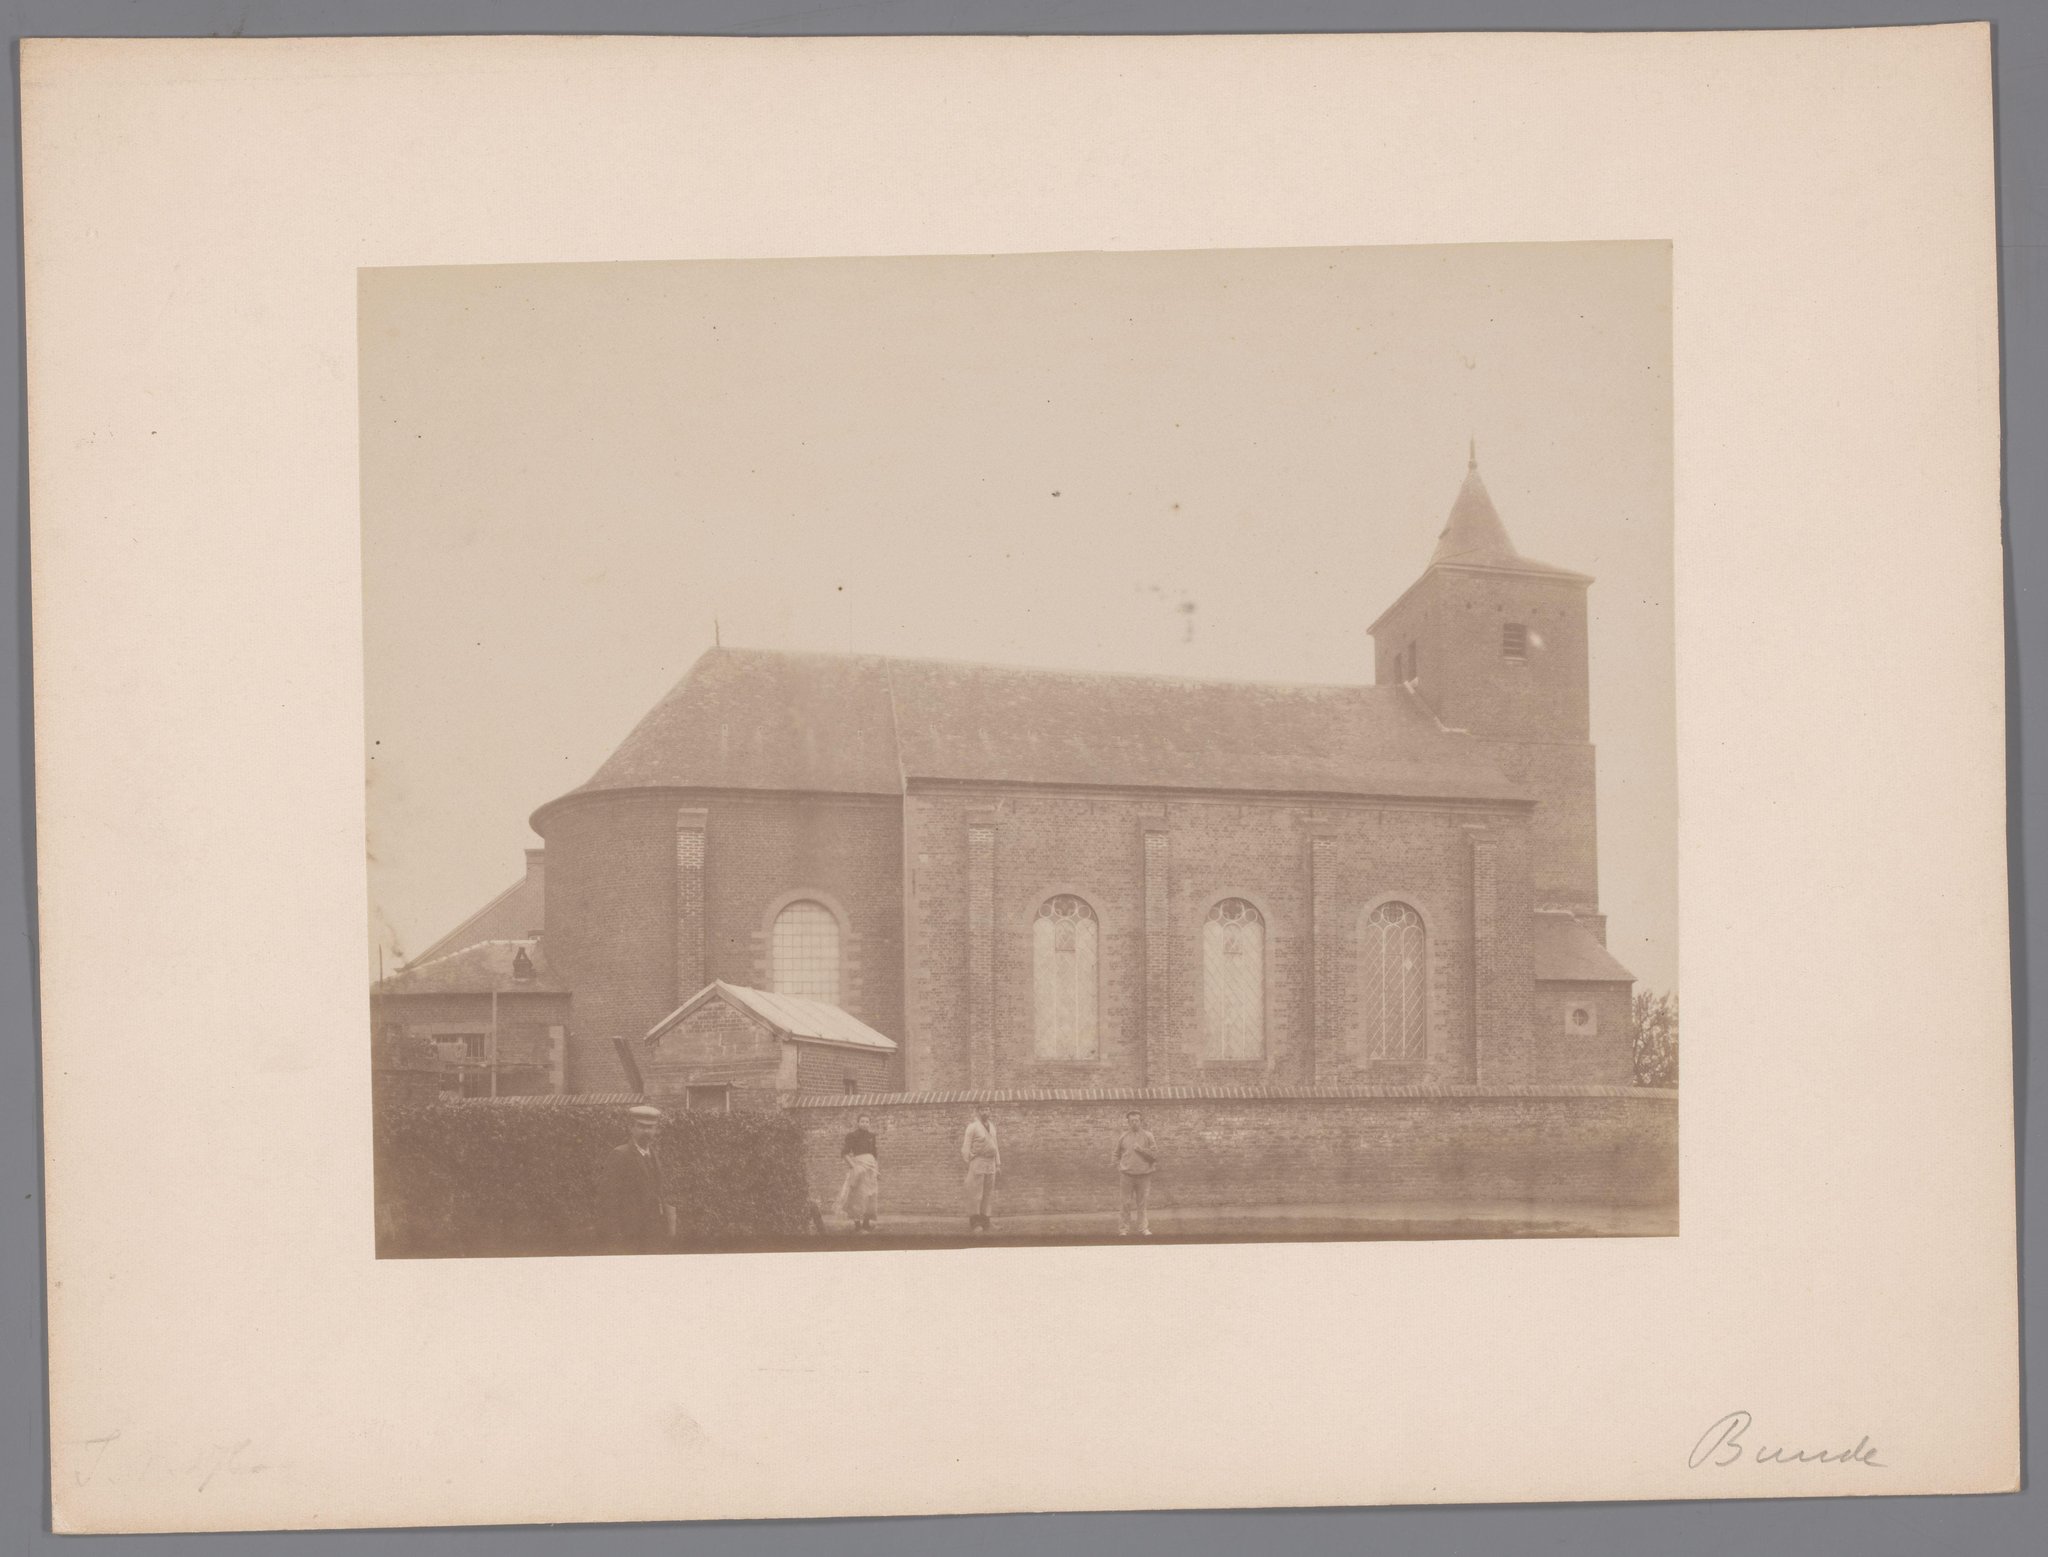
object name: photograph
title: Gezicht op de Rooms-Katholieke Kerk te Bunde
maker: anoniem (monumentenzorg)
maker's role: fotograaf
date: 1904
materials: cardboard, photographic support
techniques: albumen print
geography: bunde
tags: church (exterior)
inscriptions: annotation: ‘Bunde/ Bunde bij Maastricht/ R.K. Kerk oct 1904’, annotation: ‘Bunde’